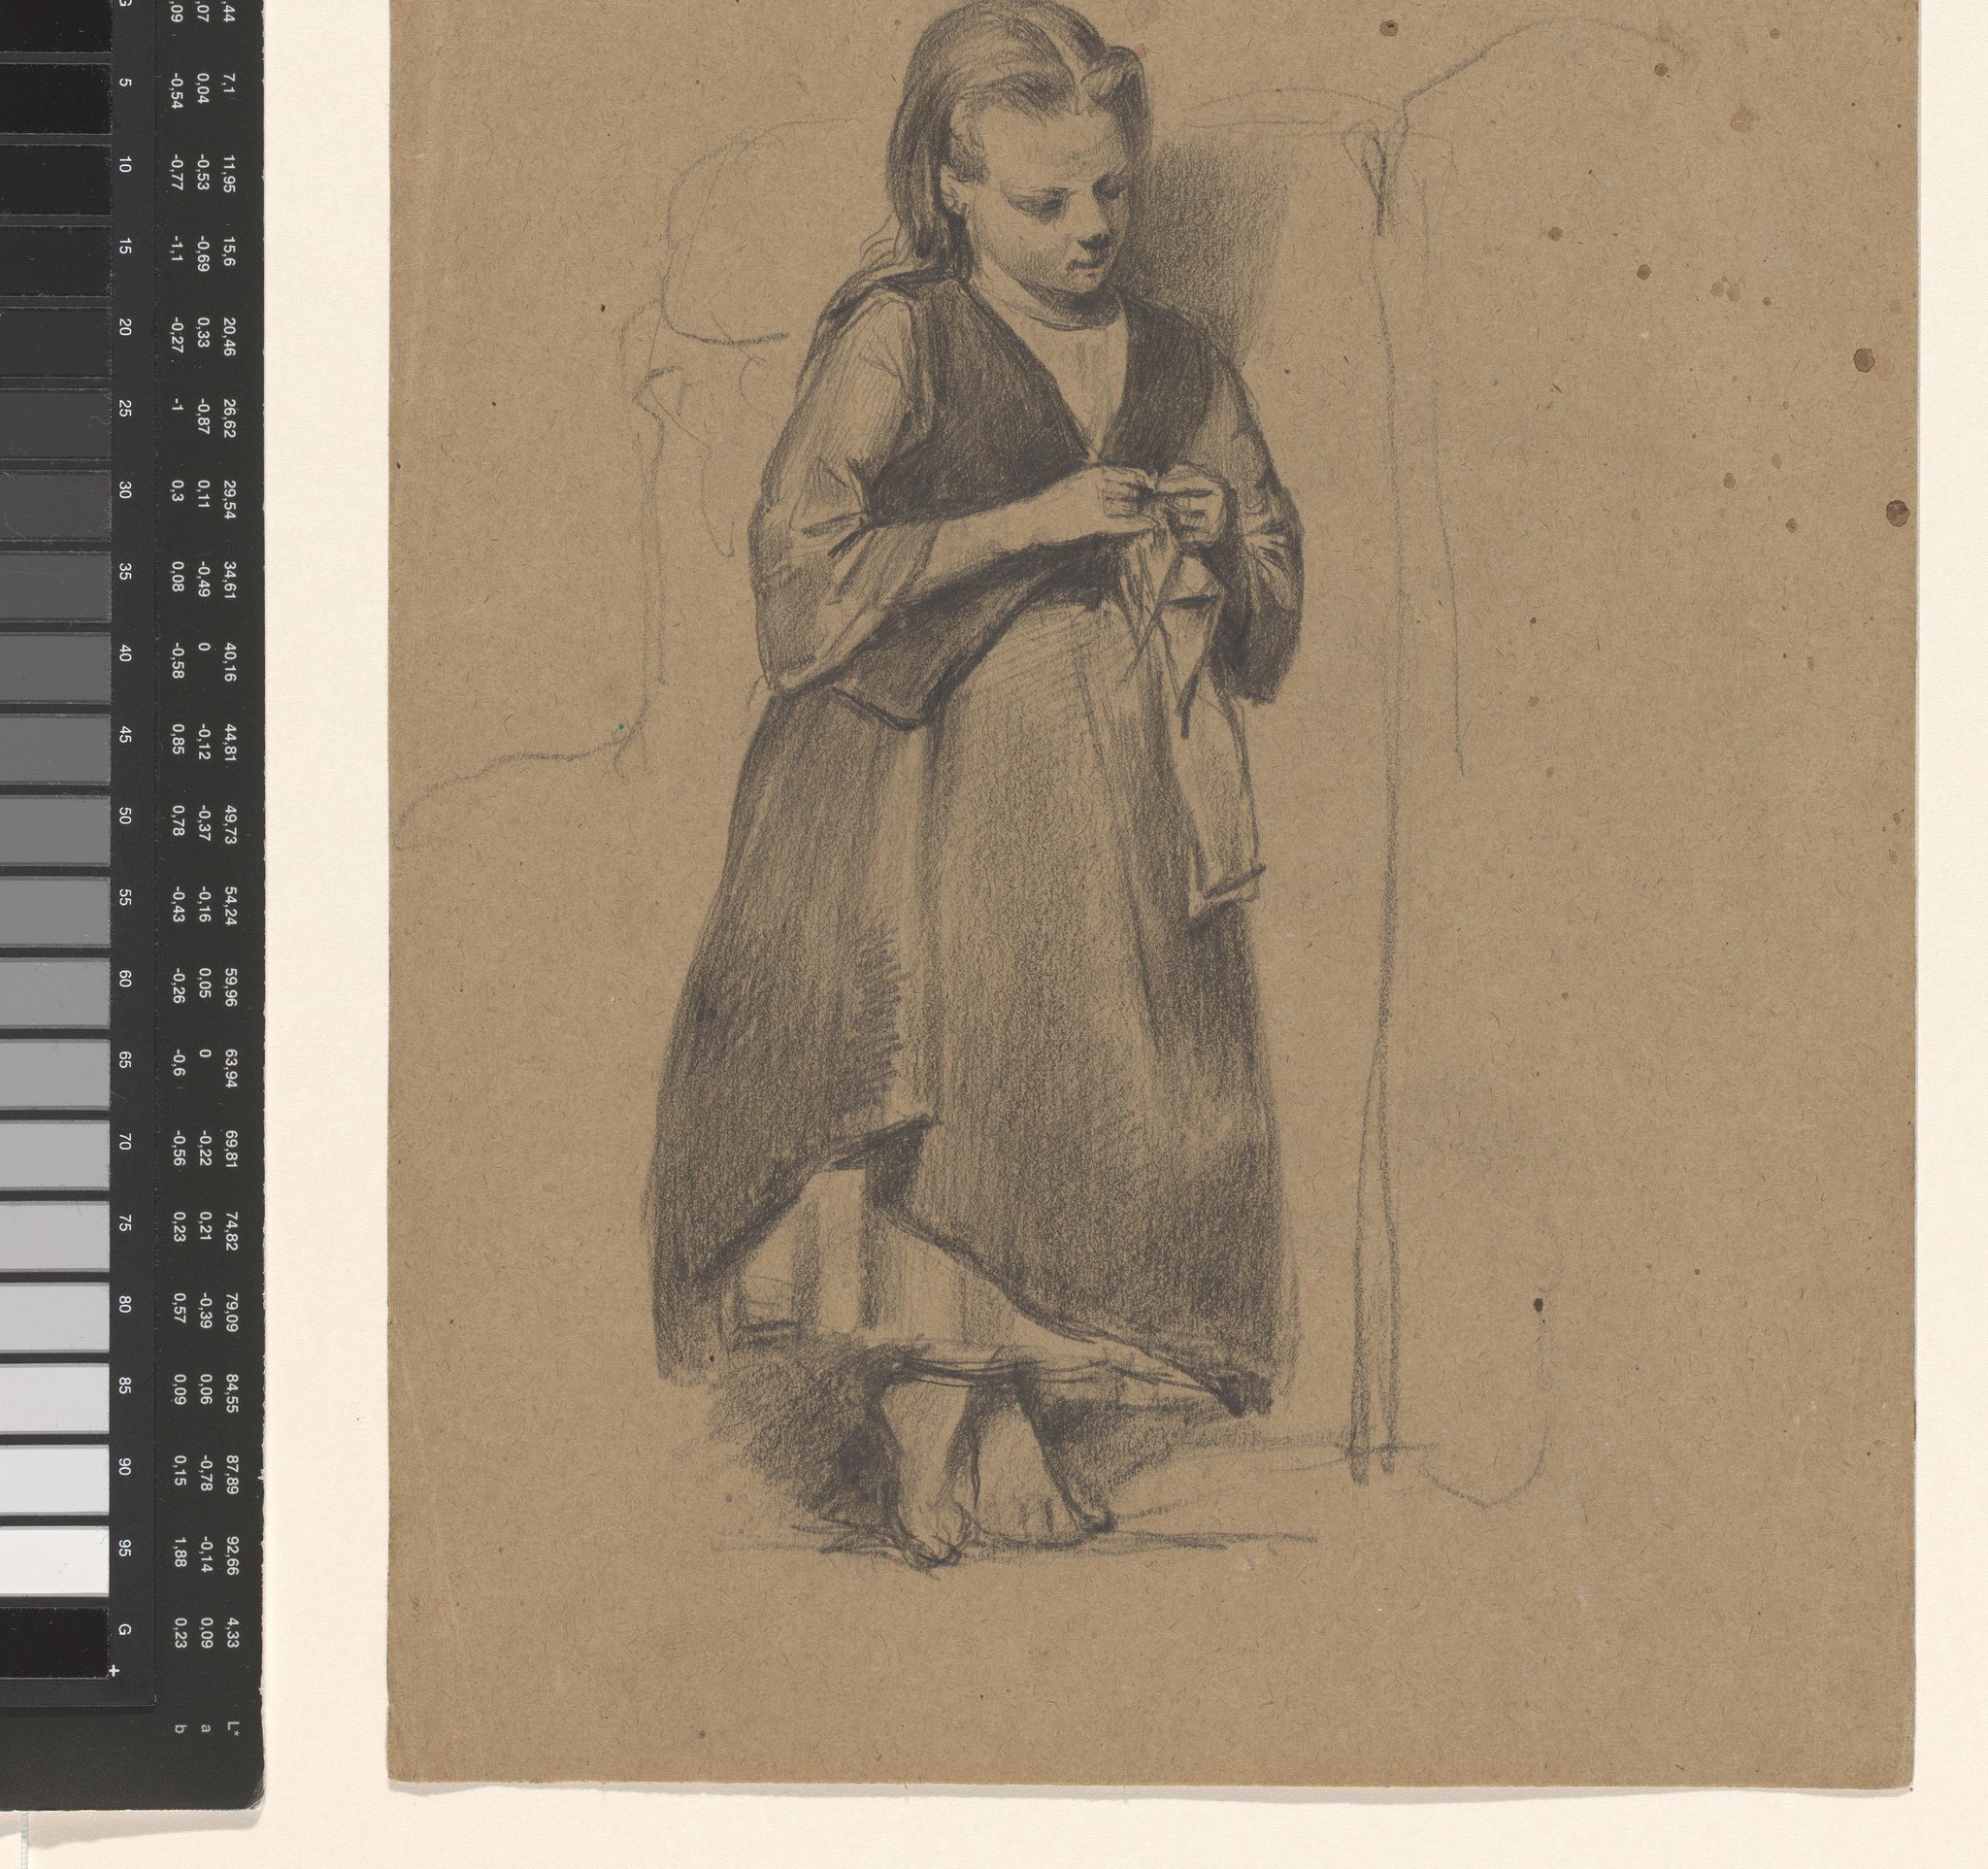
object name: drawing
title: Staand meisje met doekje in de hand, leunend tegen een achtergrond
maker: jan bedijs tom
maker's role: draughtsman, painter, print maker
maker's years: 1813-1894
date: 1823-1894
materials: paper, pencil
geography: the hague